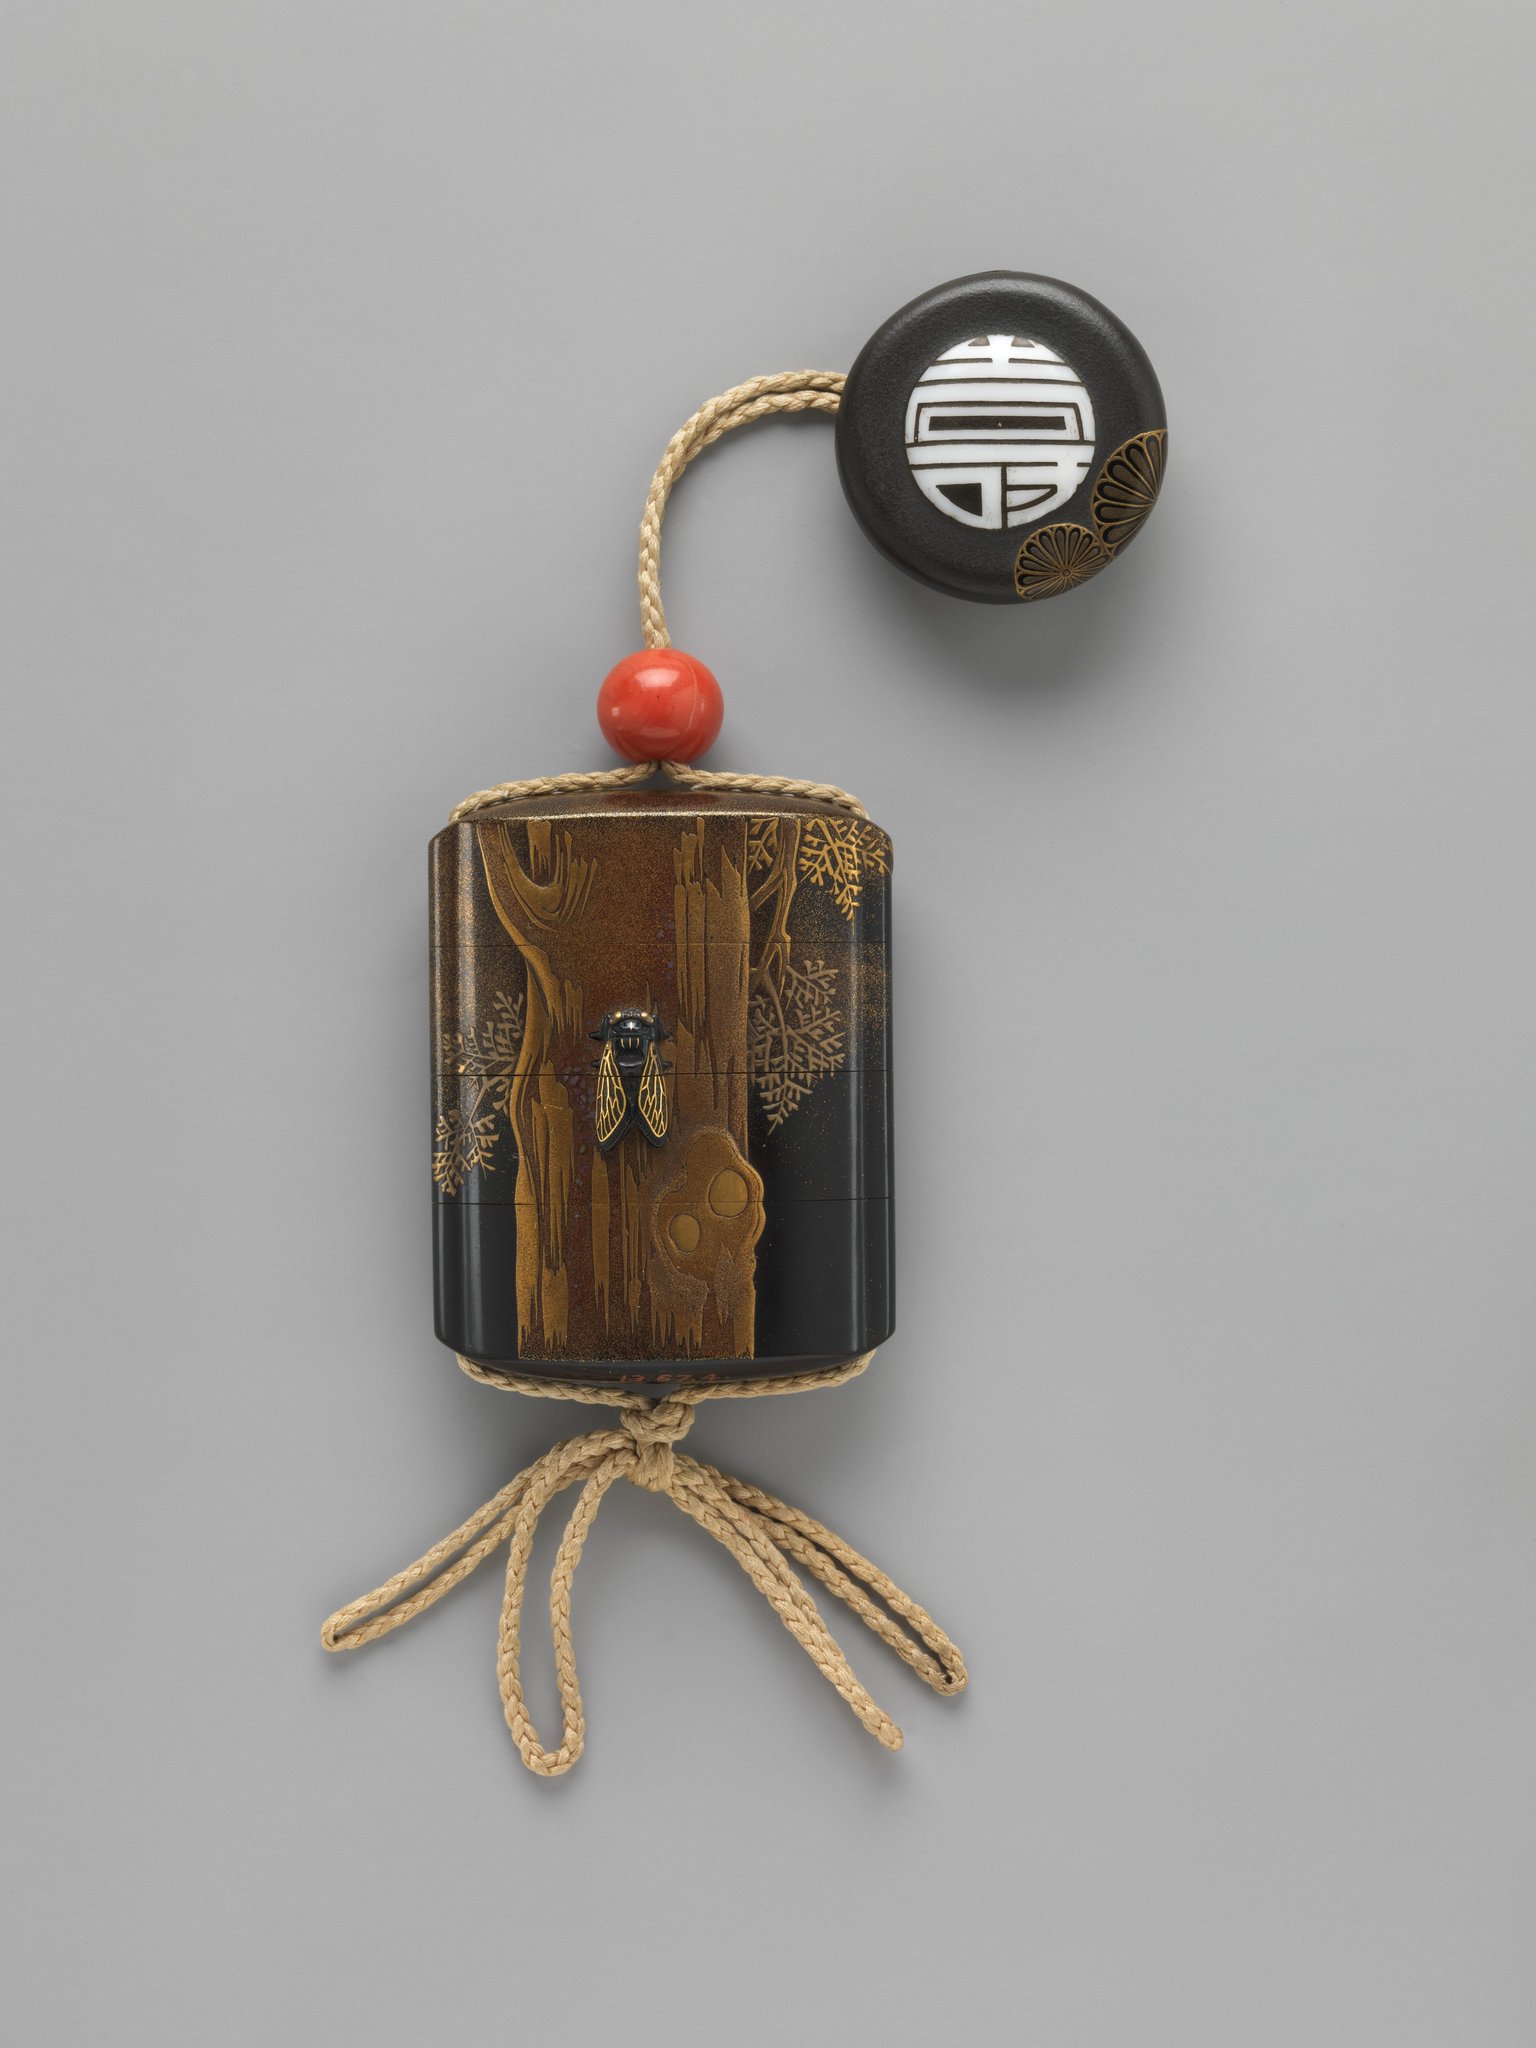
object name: inrō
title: Case (Inrō) with Design of Cicada on Tree Trunk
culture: japanese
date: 1701-1800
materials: coral, gold, lacquer, metal, mother of pearl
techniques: inlay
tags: insects,trees